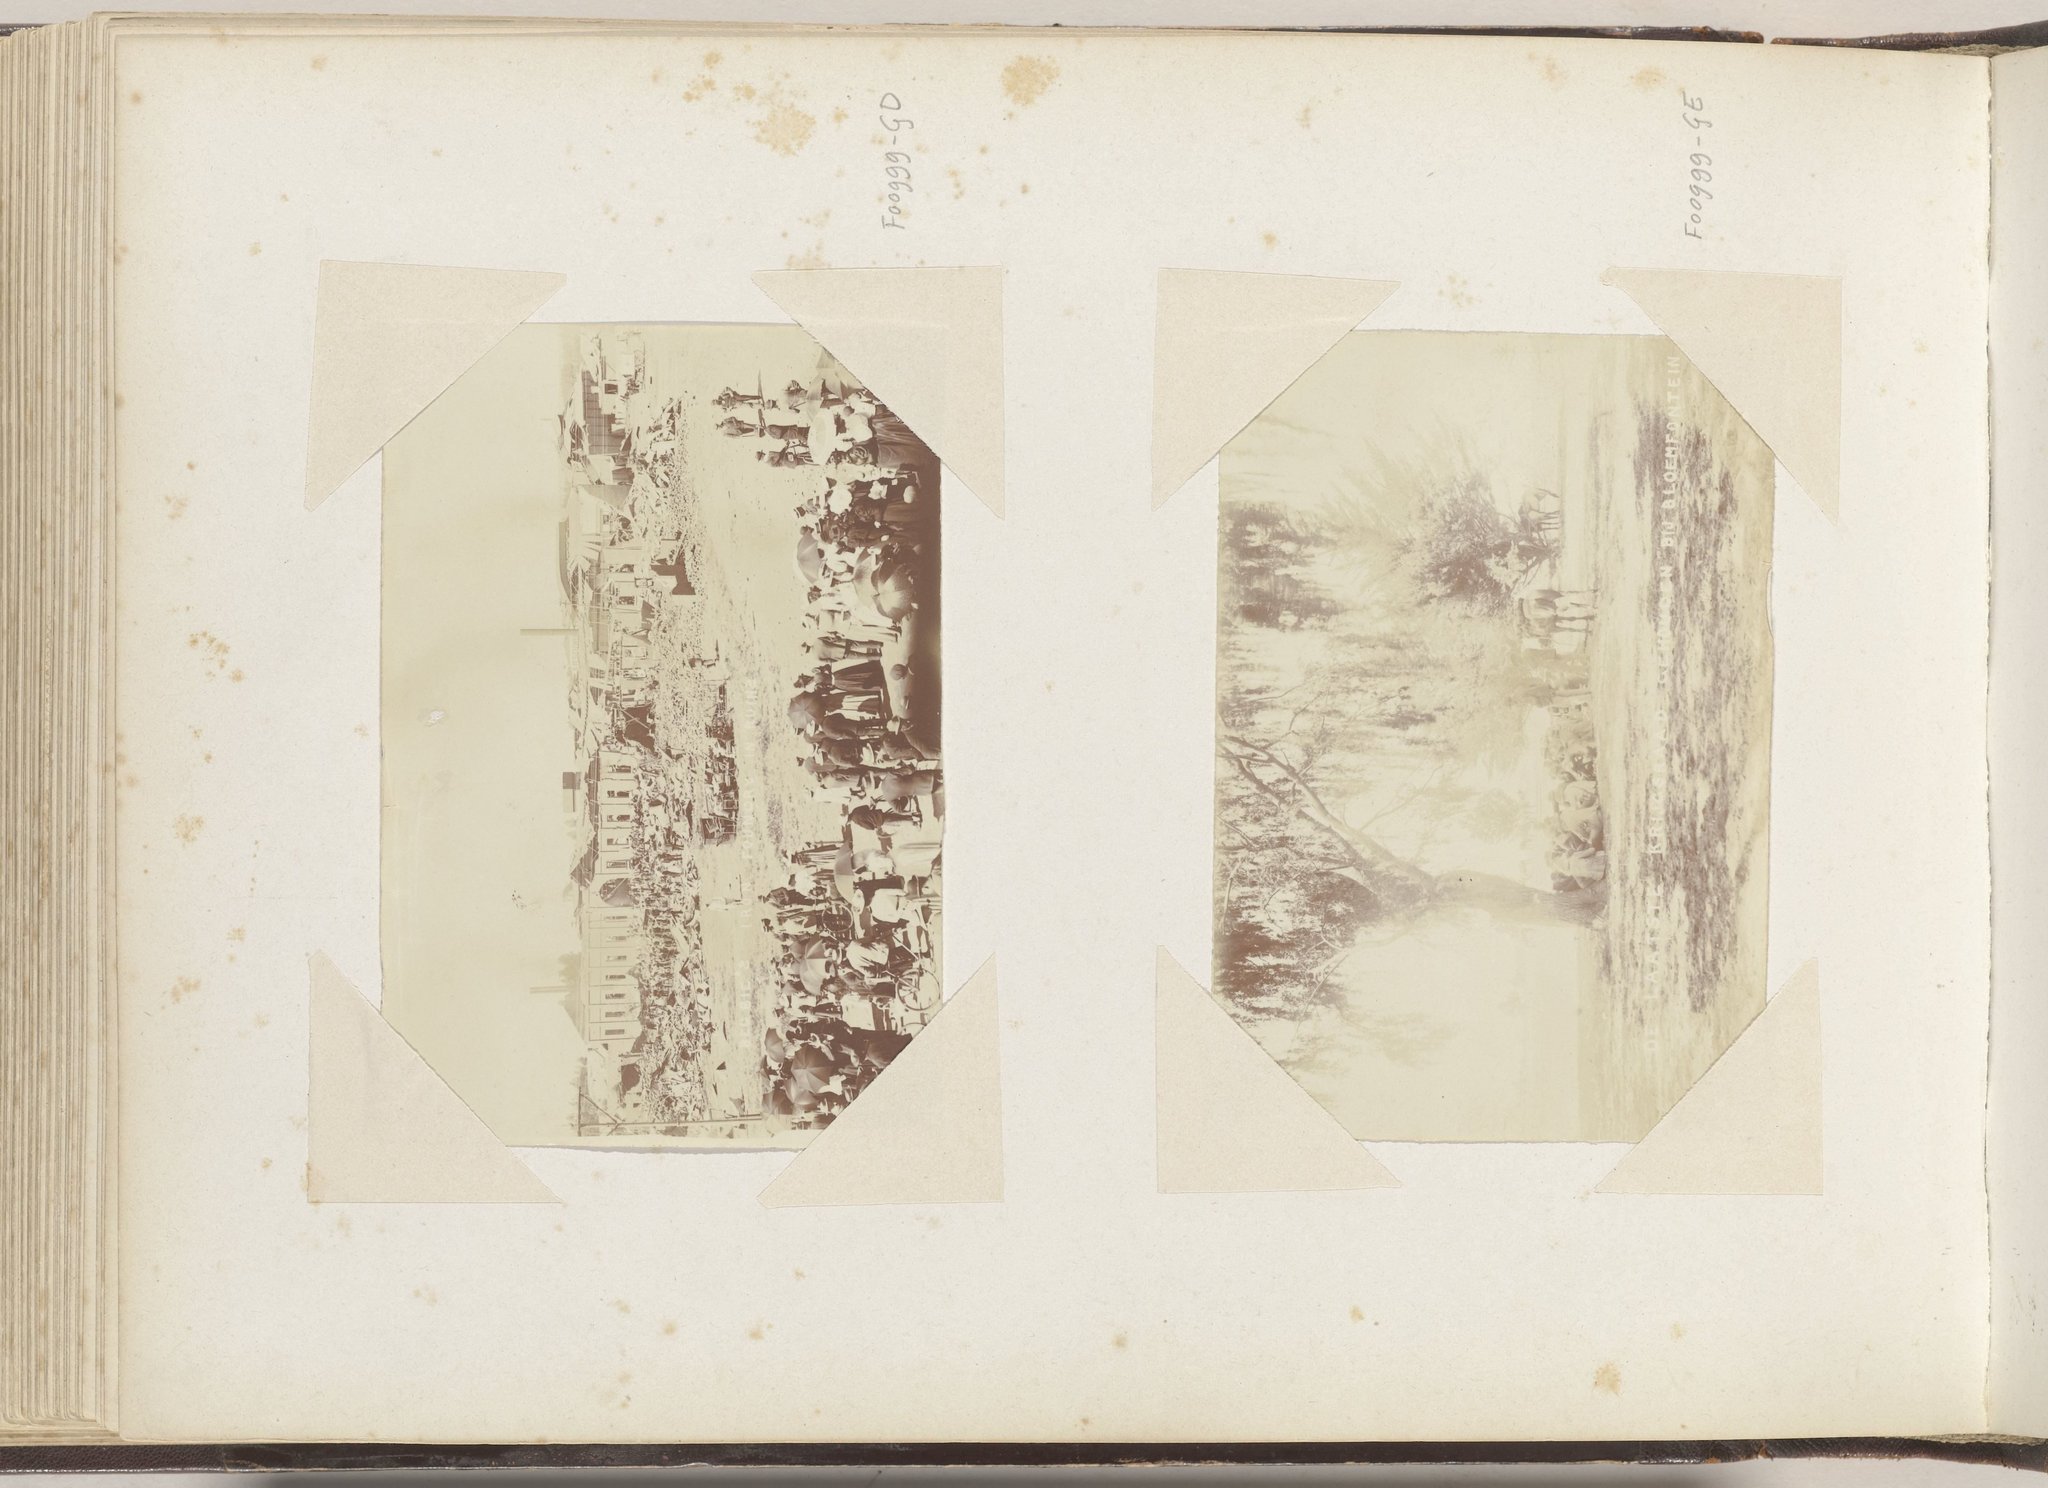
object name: photograph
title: Menigte bij een vernielde ijzergieterij in Zuid-Afrika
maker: Anonymous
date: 1899-1902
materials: paper, photographic support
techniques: gelatin silver print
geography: south africa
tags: ruin of a dwelling, house, castle, etc.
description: Onderdeel van Album met 191 foto's van een reis naar en door Zuid-Afrika.